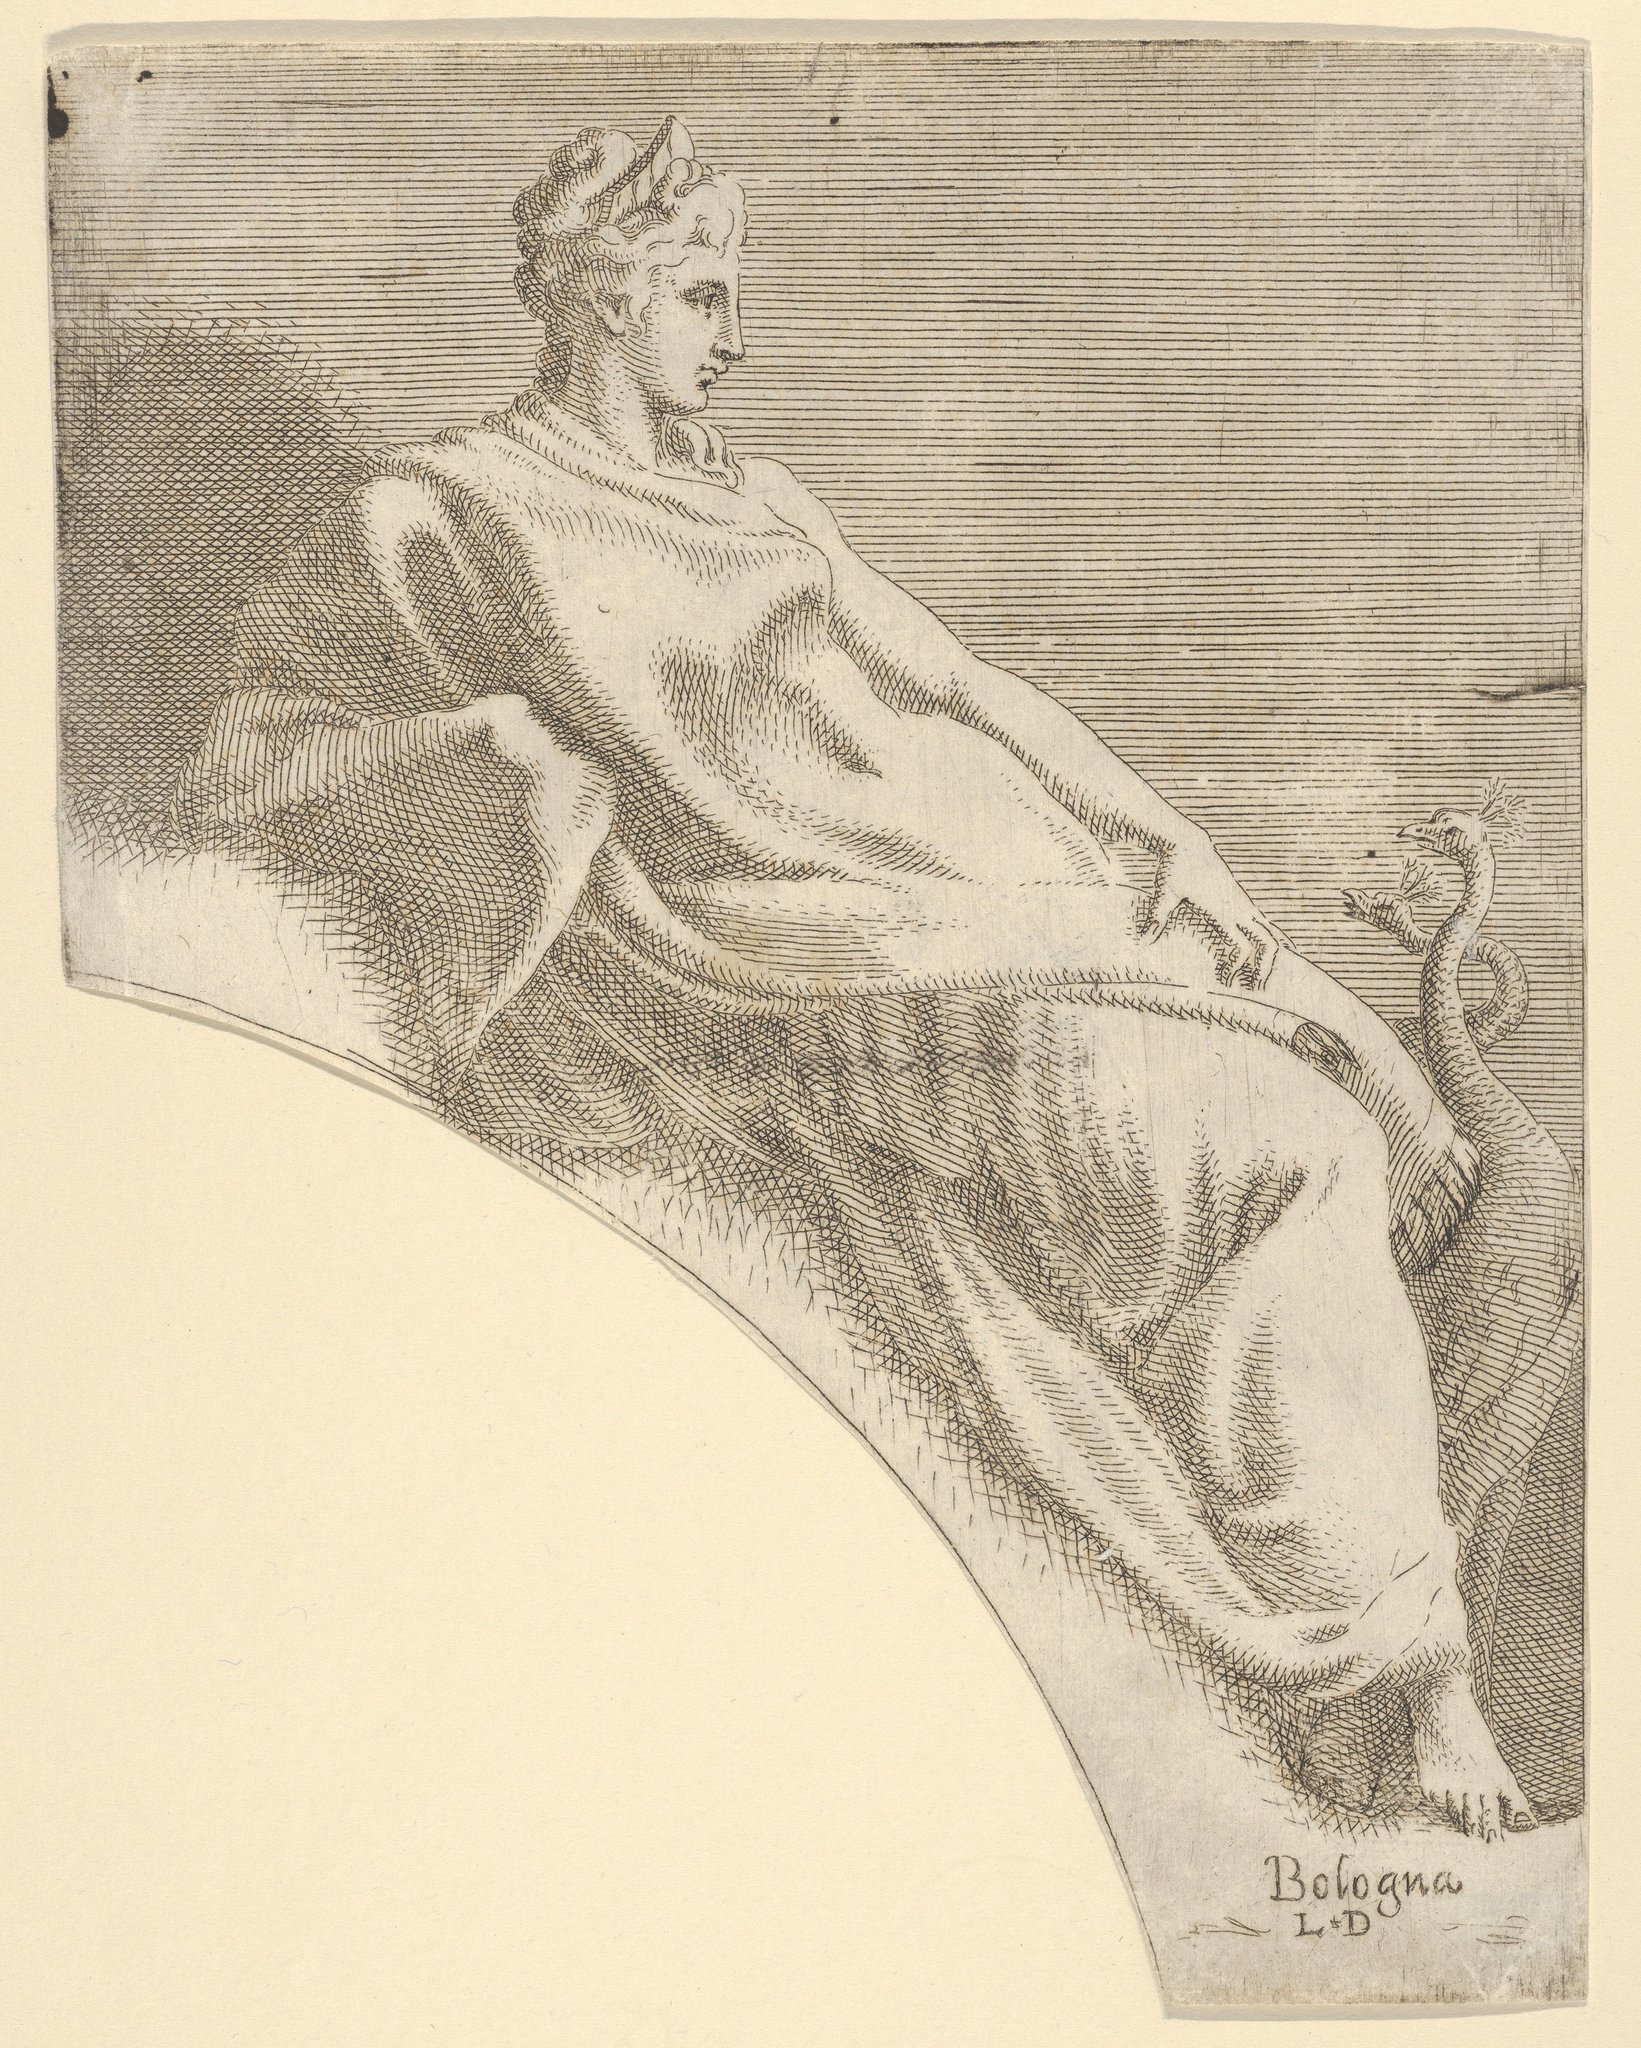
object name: print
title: Juno, from "Twelve Muses and Goddesses"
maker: léon davent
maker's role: artist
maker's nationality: french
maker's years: 1540-1556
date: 1540-1556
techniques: etching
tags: birds,juno